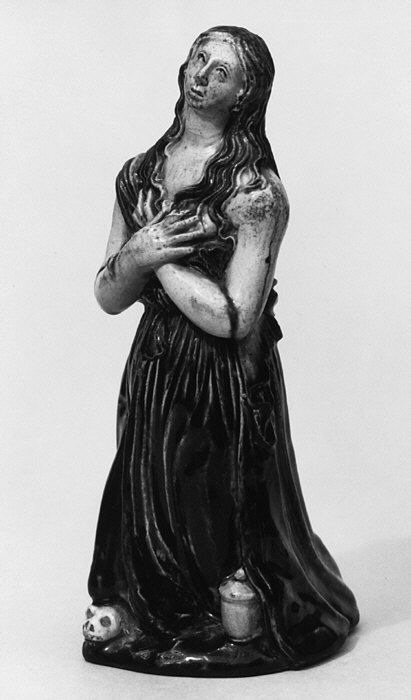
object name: figure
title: Kneeling Magdalene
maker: barthélémy de blénod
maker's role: maker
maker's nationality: french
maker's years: 1800-1900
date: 1801-1900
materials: earthenware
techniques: glazing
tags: mary magdalene